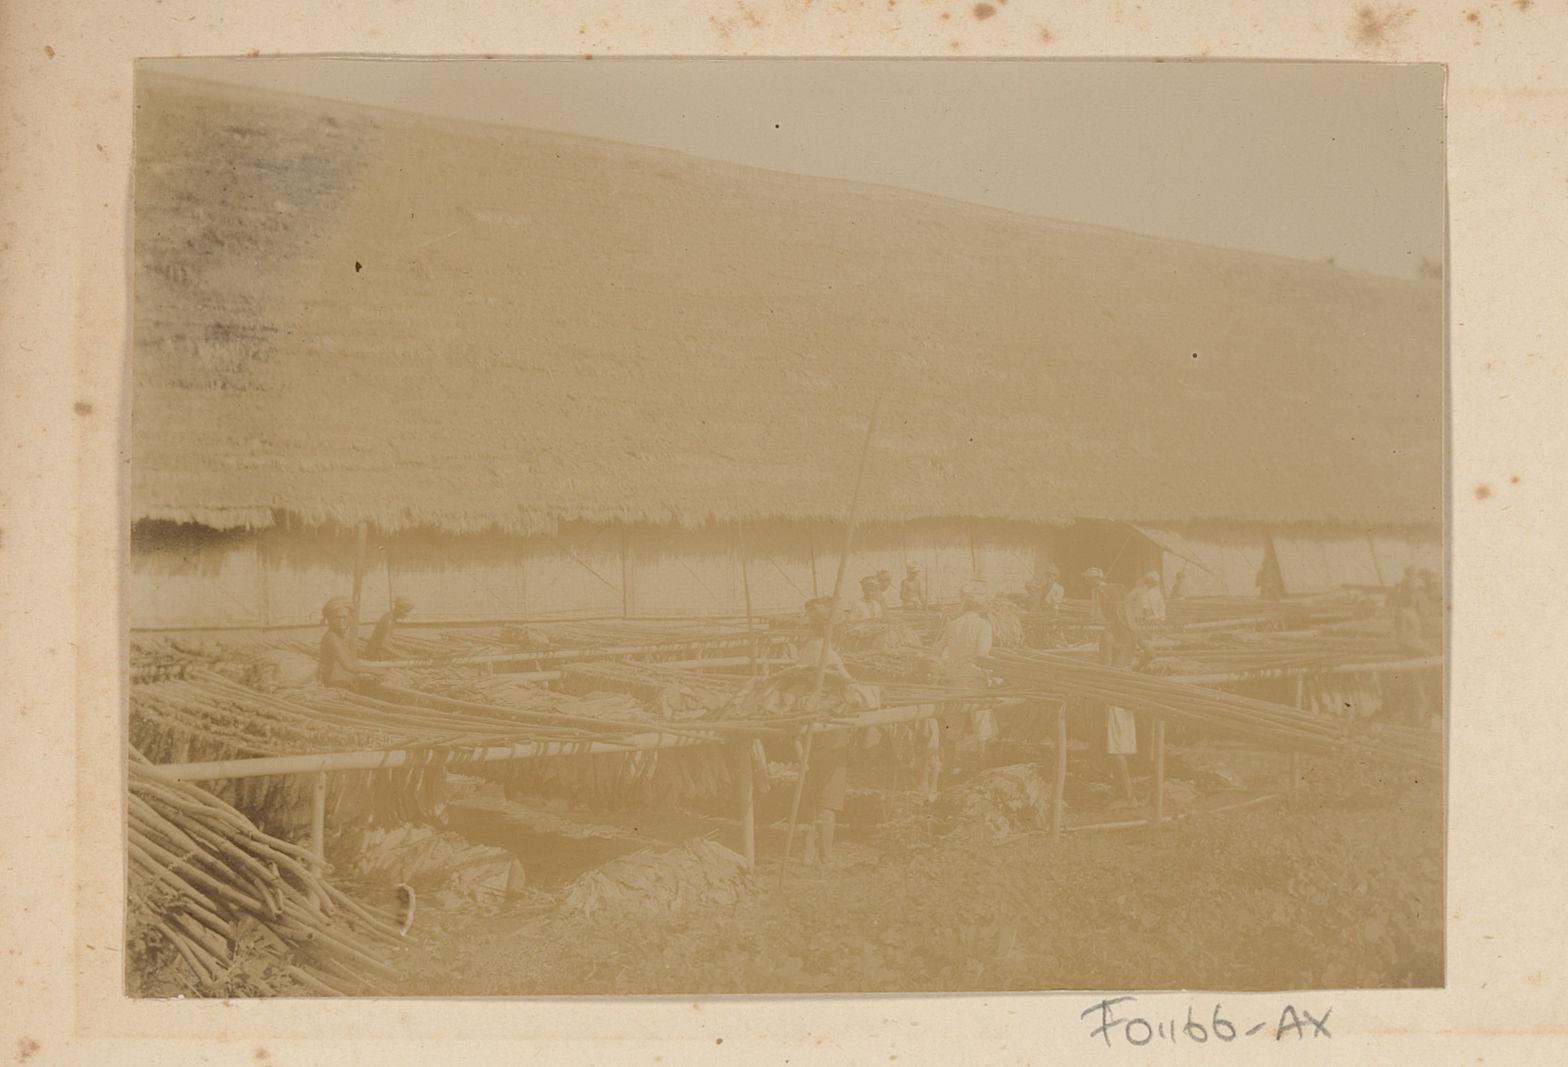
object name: photograph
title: Bouwwerkzaamheden naast een schuur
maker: Anonymous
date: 1890-1910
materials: photographic support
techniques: gelatin silver print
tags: annexes and outbuildings; fencing; gate, building activities, dutch east indies, the